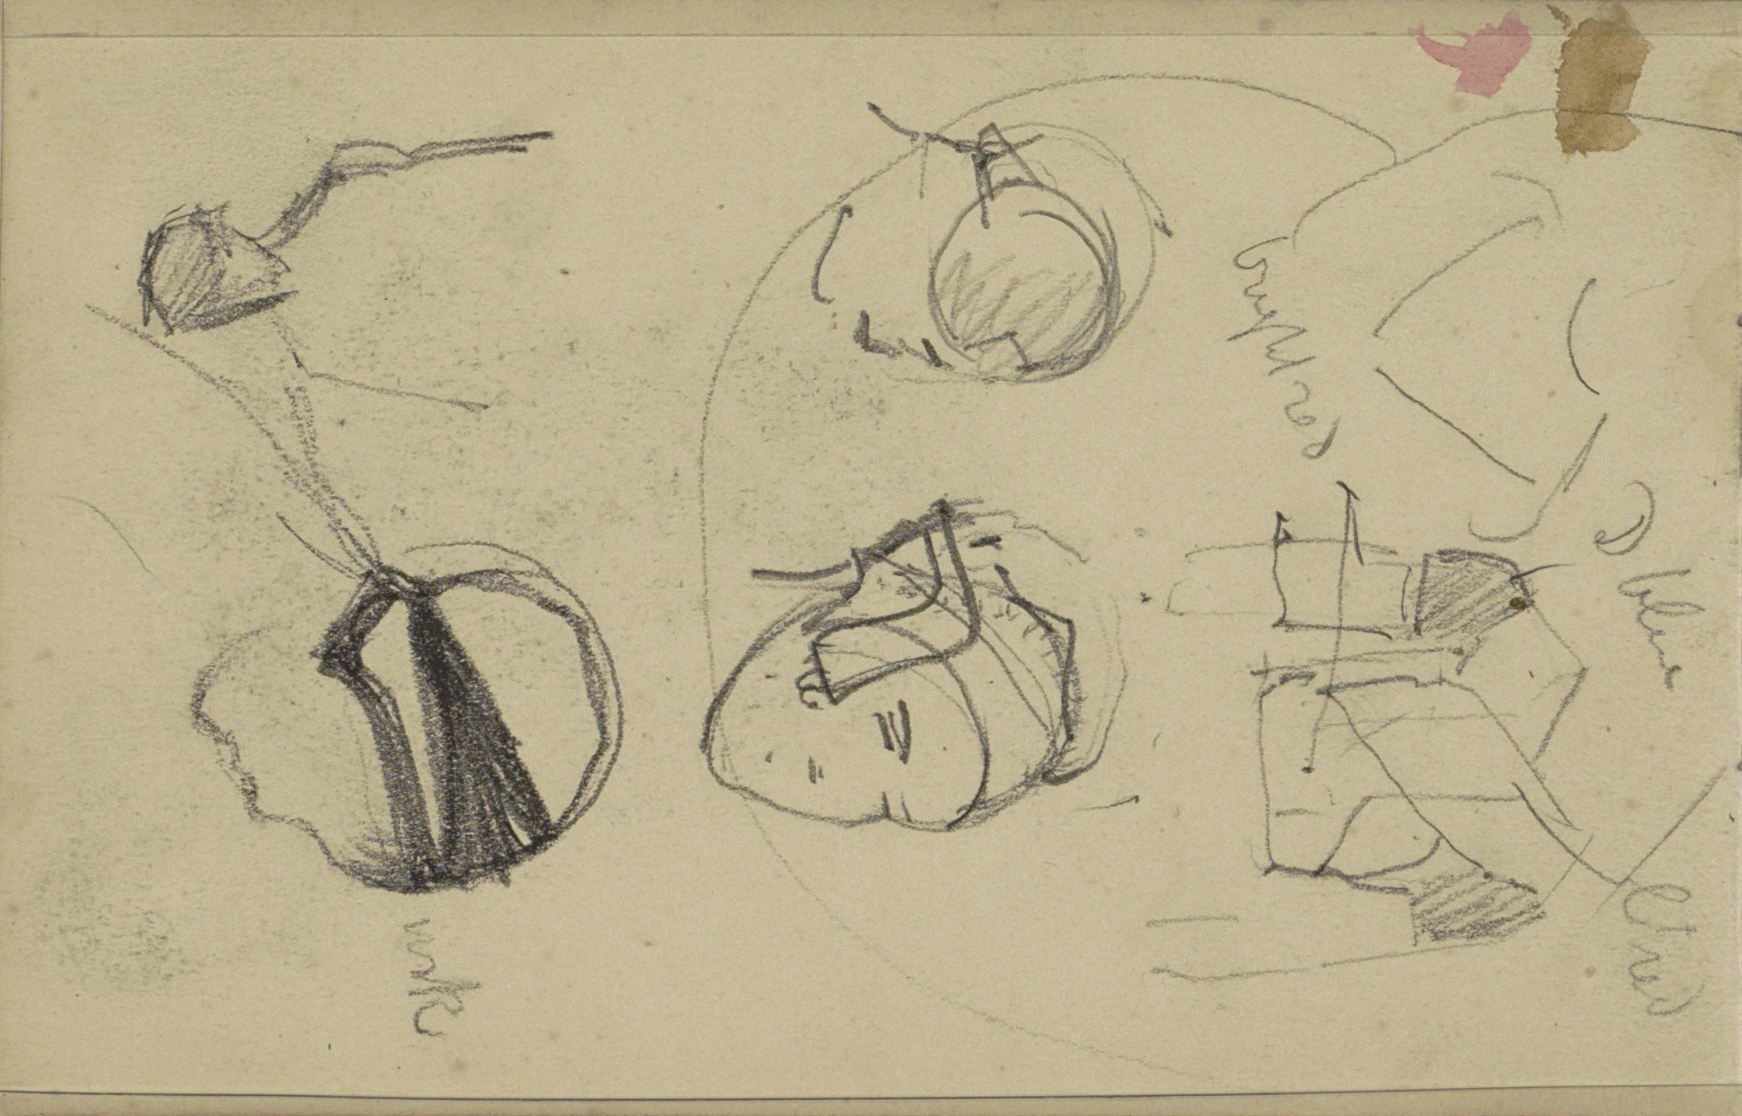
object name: sketchbook leaf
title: Koppen met Urker hoofddeksels en een blouse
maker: george clausen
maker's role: draughtsman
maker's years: 1852-1912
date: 1875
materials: paper, pencil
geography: urk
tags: folk costume, regional costume (+ women's clothes)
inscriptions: annotation: ‘urk’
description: Blad 27 verso uit een schetsboek met 38 bladen.